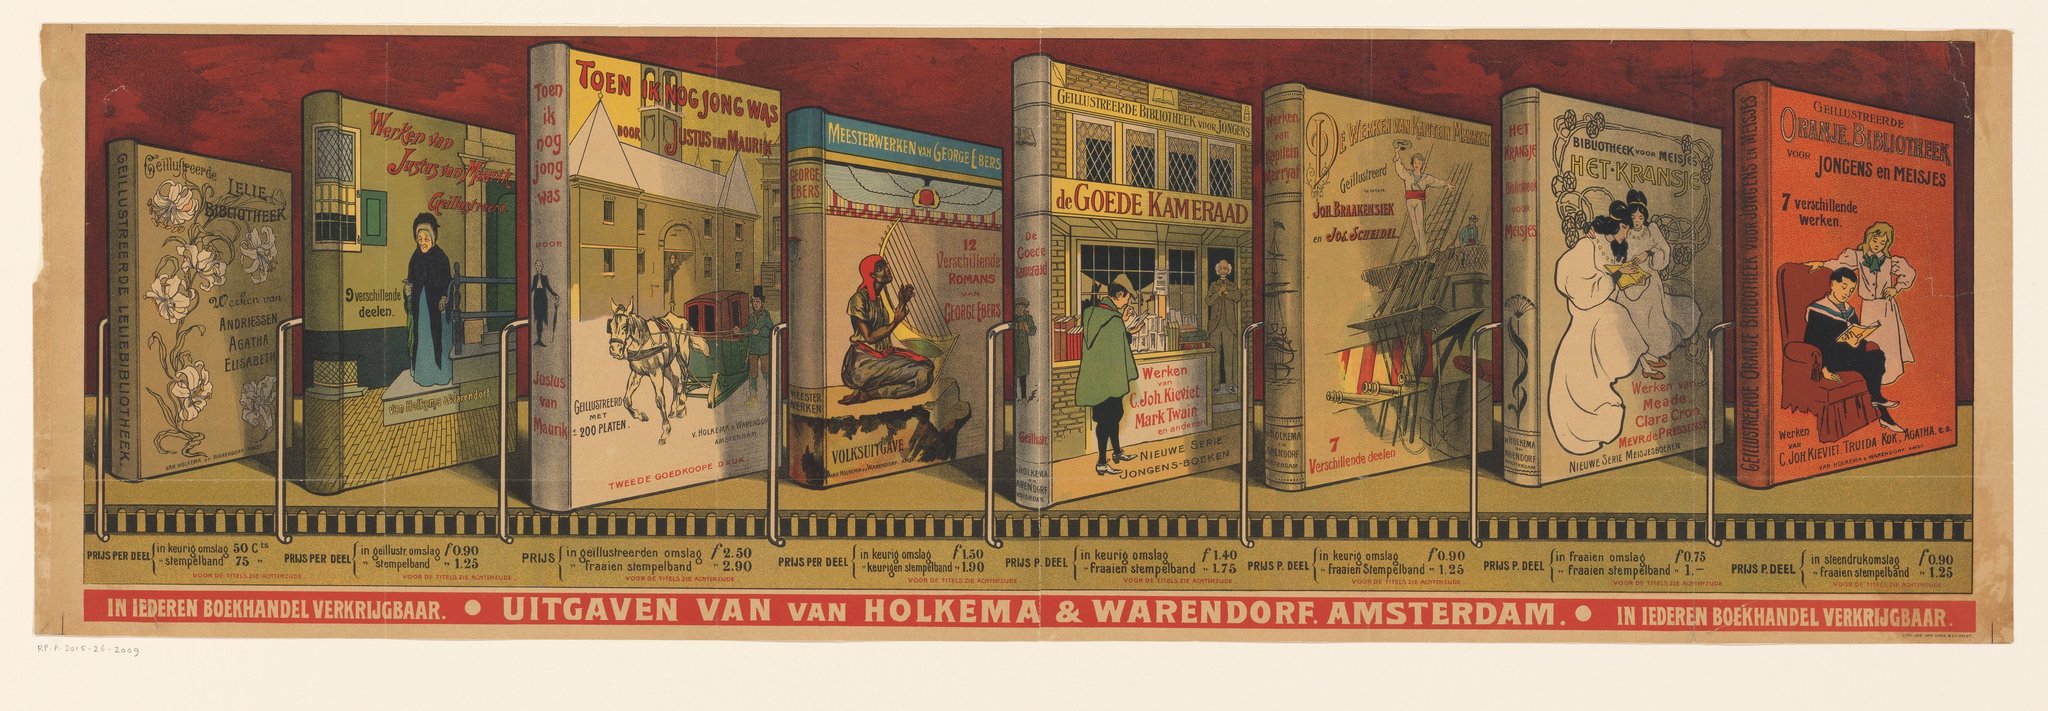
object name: print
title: Affiche van uitgever Holkema & Warendorf te Amsterdam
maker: Anonymous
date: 1903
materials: paper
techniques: lithograph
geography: amsterdam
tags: book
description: Boekenplank met de boekbanden van acht verschillende series uitgegeven door Holkema & Warendorf te Amsterdam. De titels worden vermeld op verso.